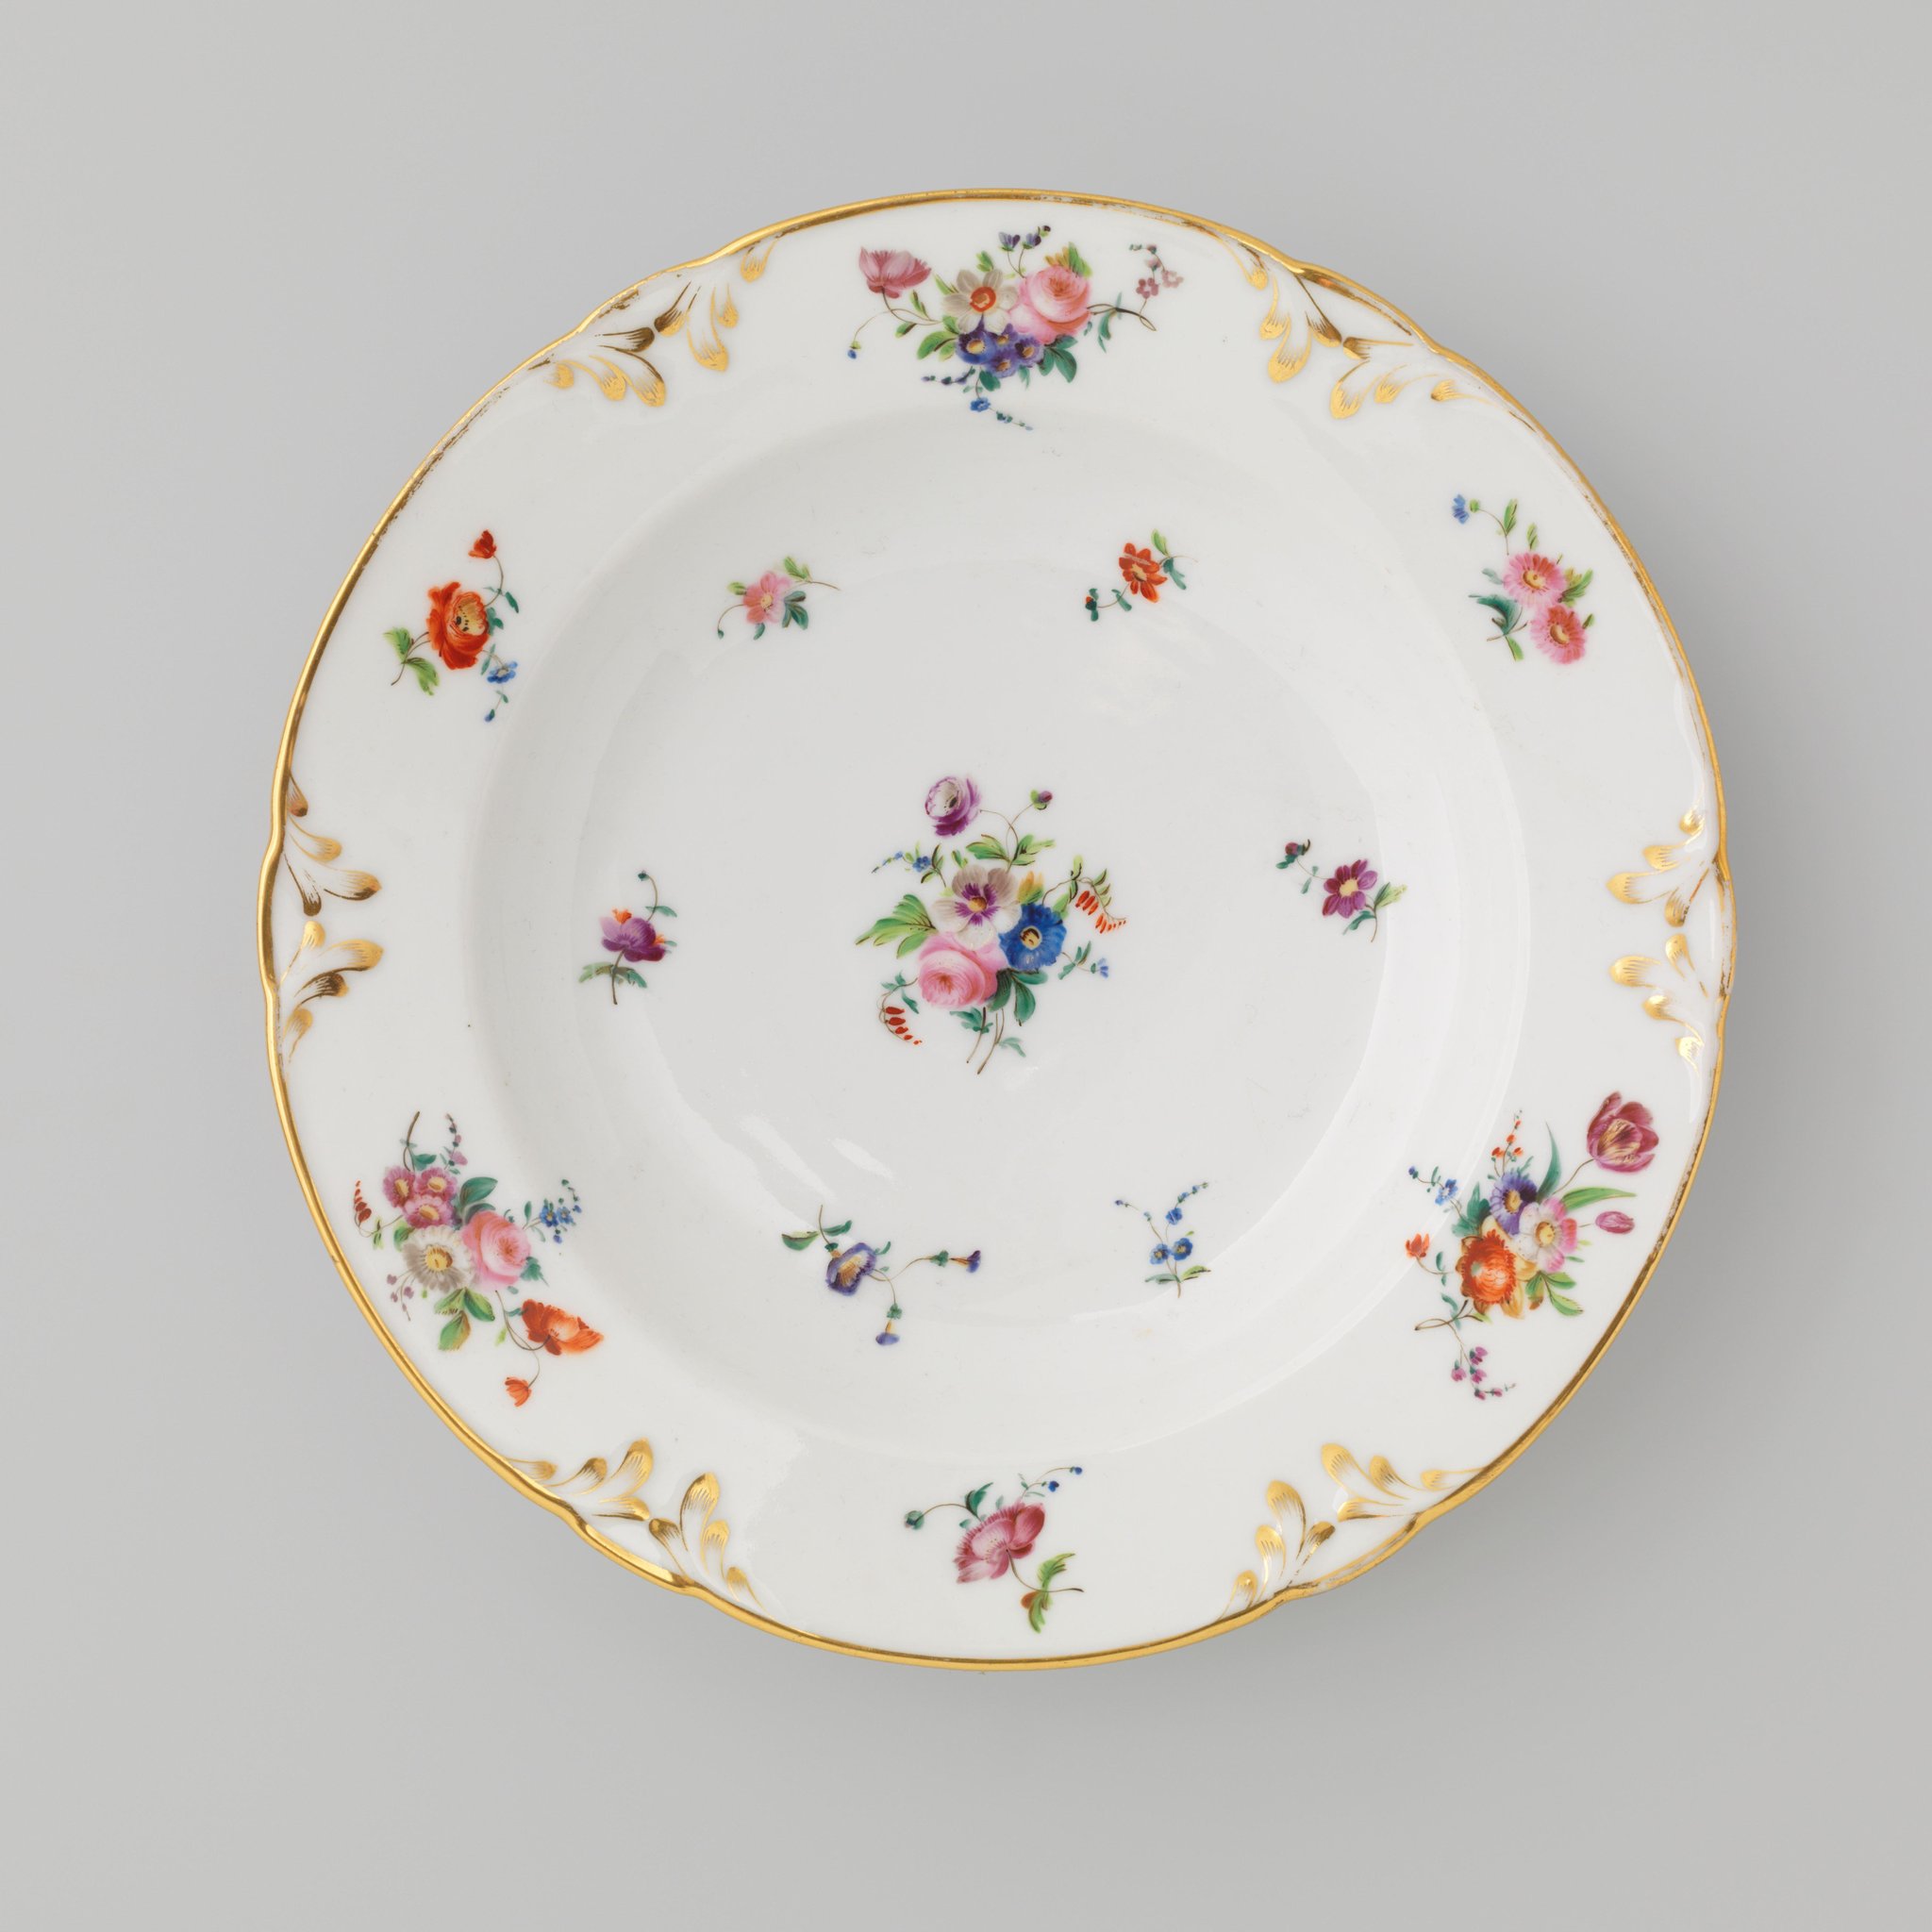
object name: service set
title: Plate with bouquets and flower sprays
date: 1839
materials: glaze, gold, paint, porcelain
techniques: firing, forming, gilding, turning, vitrification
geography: paris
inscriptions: mark: ‘DENUELLE/ Boulevard St. Denis 18/ à Paris’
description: Diep bord van porselein met een gelobde rand, beschilderd op het glazuur in blauw, rood, roze, groen, geel, paars, zwart en goud. Op het plat boeketten van verschillende bloemen en strooibloemen. Vanuit de gelobde, gouden rand, gemodelleerde bladranken in reliëf, aangezet met goud. Hiertussen boeketten. Drie proenen op de onderzijde. Gemerkt op de onderzijde met 'DENUELLE/ Boulevard St. Denis 18/ à Paris'.